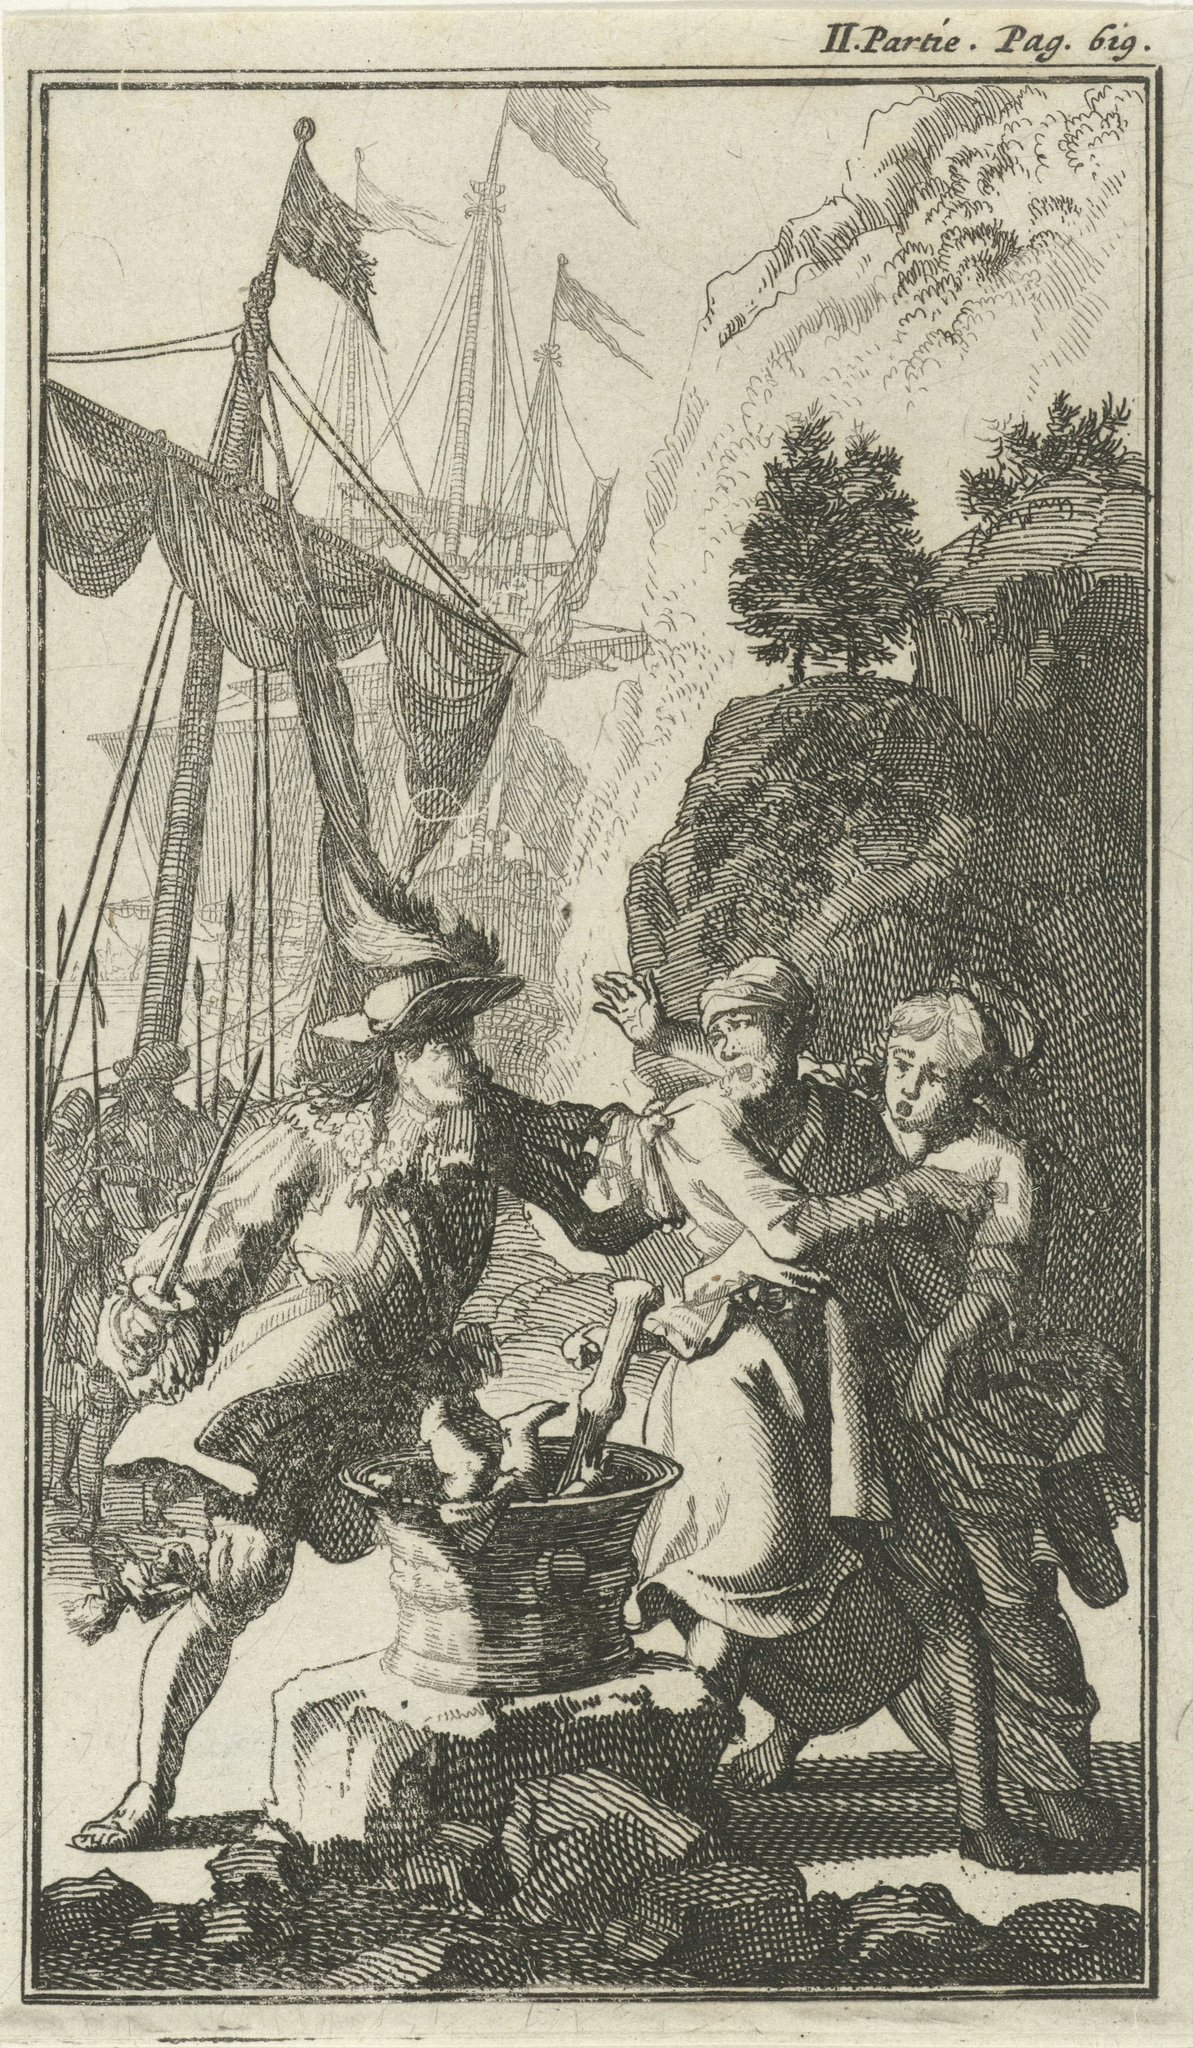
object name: book illustration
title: Portugese admiraal Fereyra Andrade dwingt ouders hun zuigeling in een mortier te doden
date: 1689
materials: paper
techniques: etching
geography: paris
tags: parents with their children, violent death, being killed; being mishandled and maltreated; seeking death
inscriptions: collector's mark: Lugt 2228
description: Illustratie uit: Thevenot, Jean de. Voyages Tant en Europe qu'en Asie et en Afrique, 4 delen. Parijs: Charles Angot, 1689, dl. III.